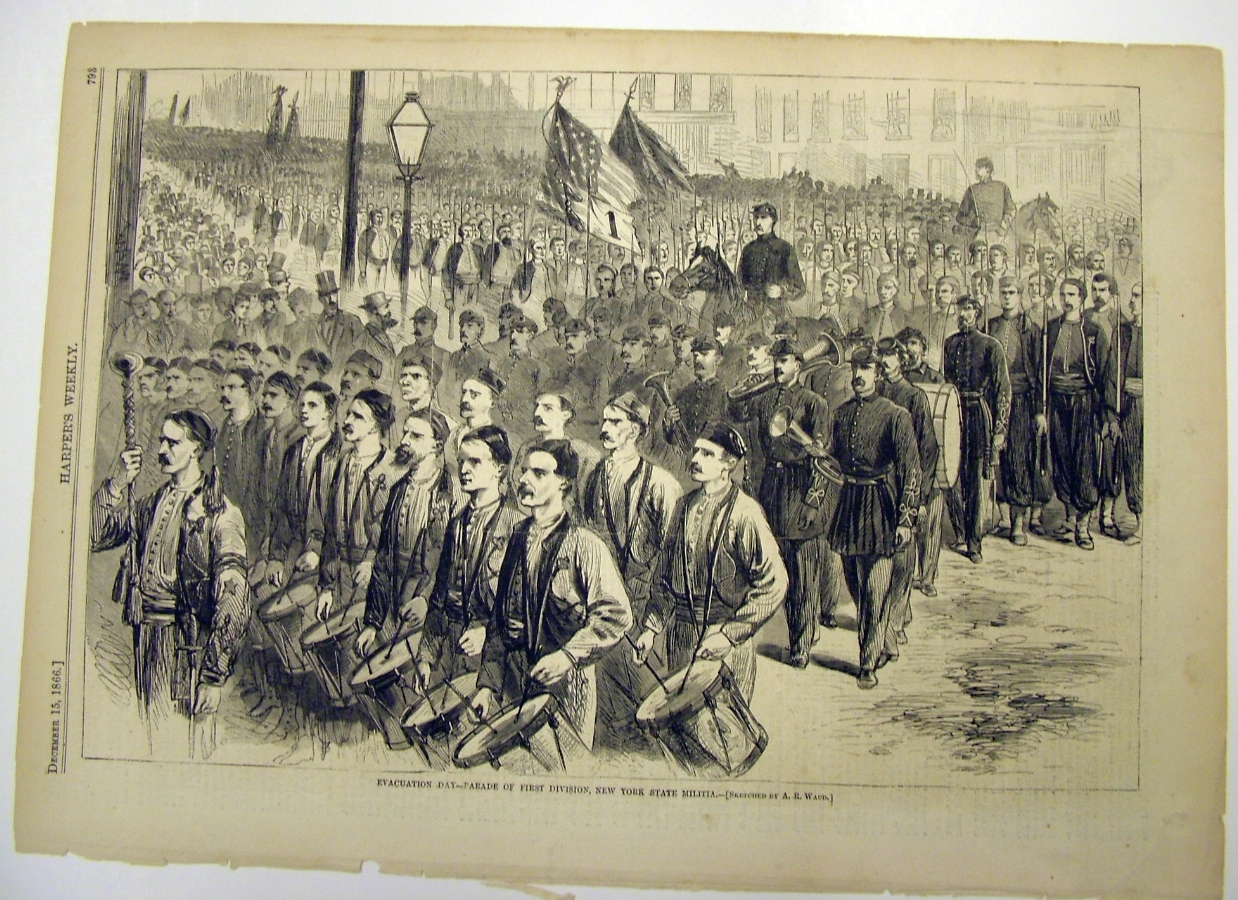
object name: newspaper illustration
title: Evacuation Day Parade of First Division, New York State Militia, newspaper illustration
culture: american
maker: alfred rudolf waud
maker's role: artist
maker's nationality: american, born england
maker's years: 1828-1891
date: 1866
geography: united states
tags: soldiers,men